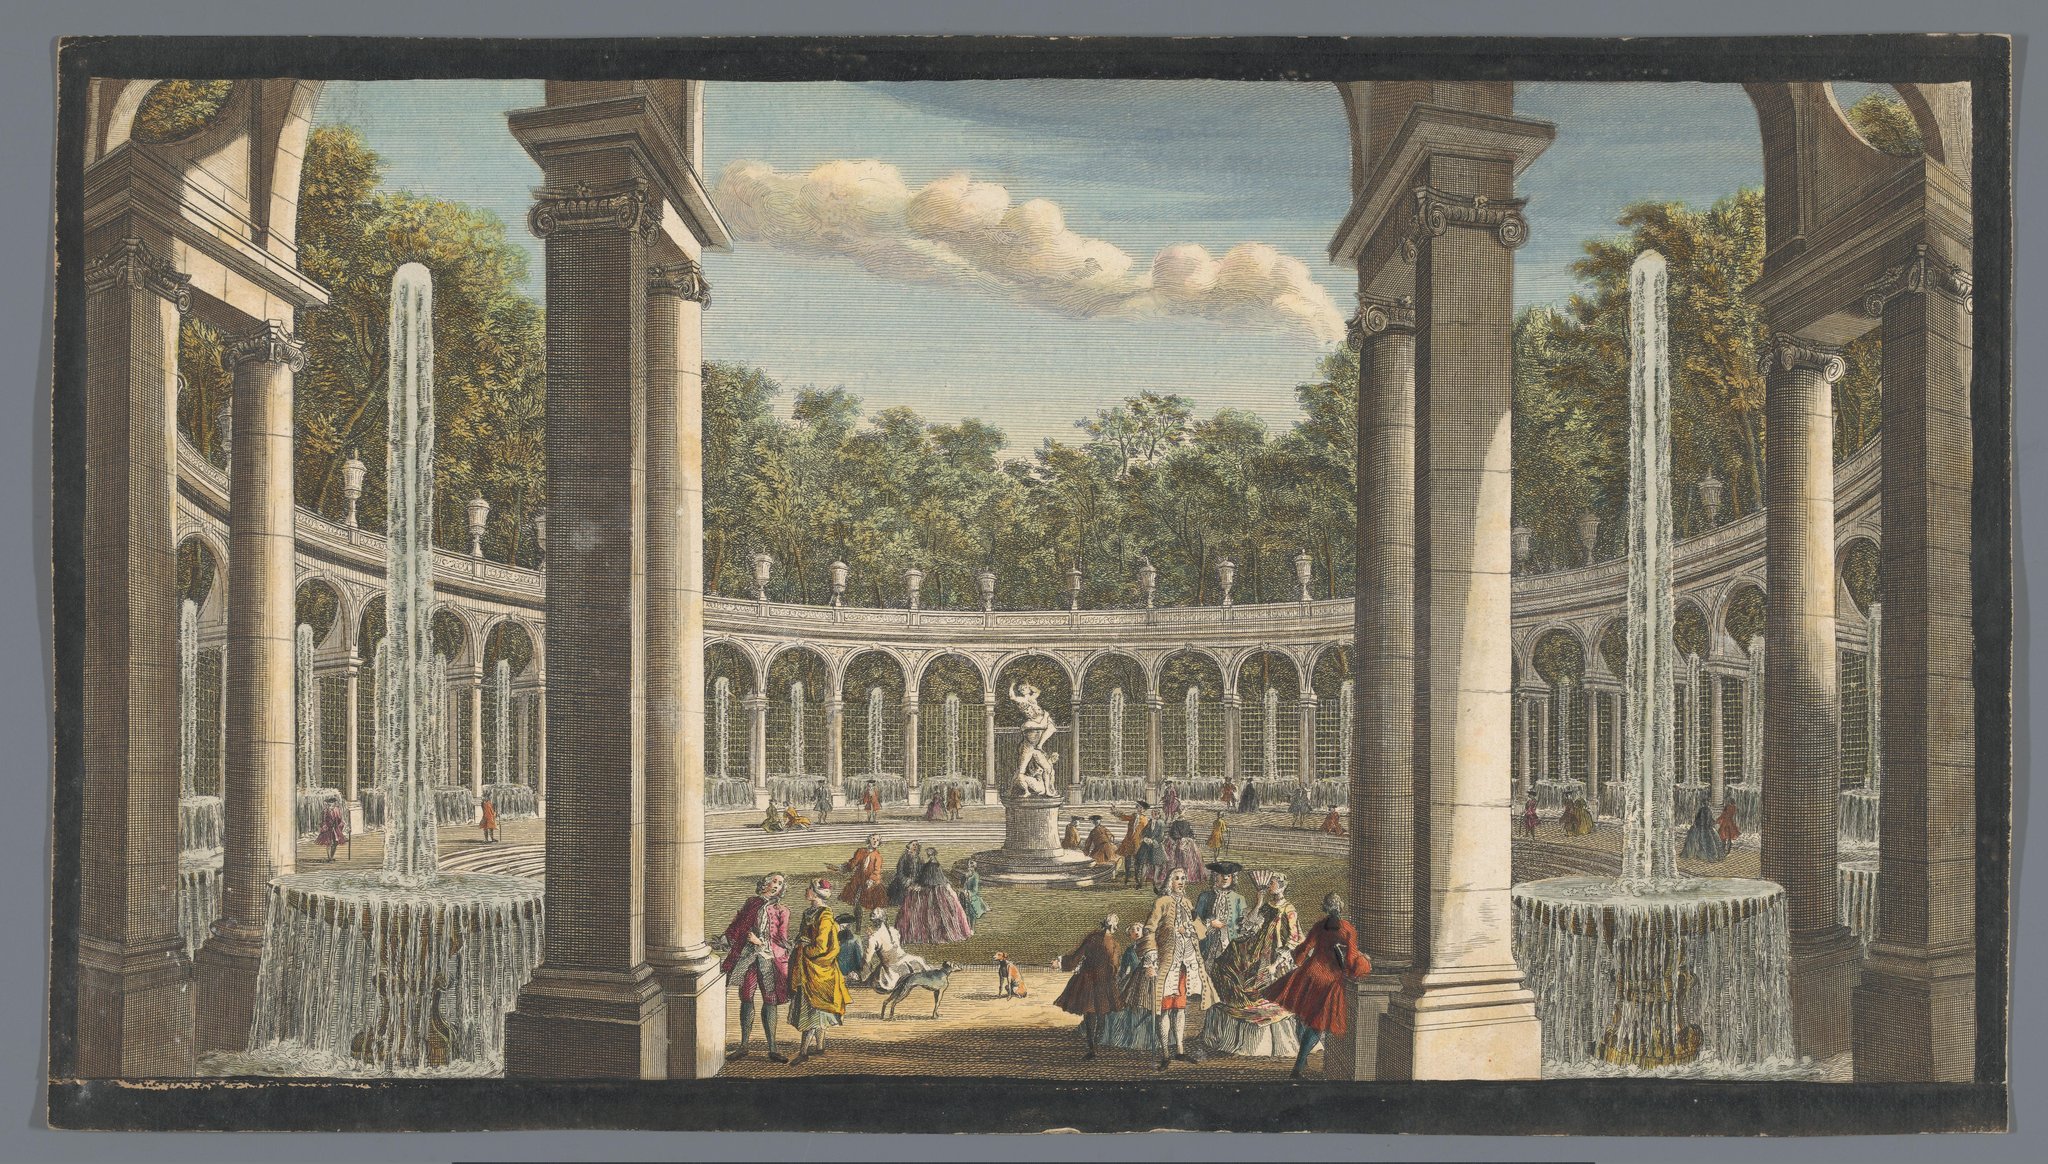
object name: print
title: The Colonnade in the Garden at Versailles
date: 1700-1761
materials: cardboard, paper, watercolor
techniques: brush, etching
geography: england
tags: garden, garden fountain, garden ornaments, garden buildings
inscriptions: inscription: ‘Fo 11 B4’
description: In de ondermarge twee regels Franse en twee regels Engelse tekst.